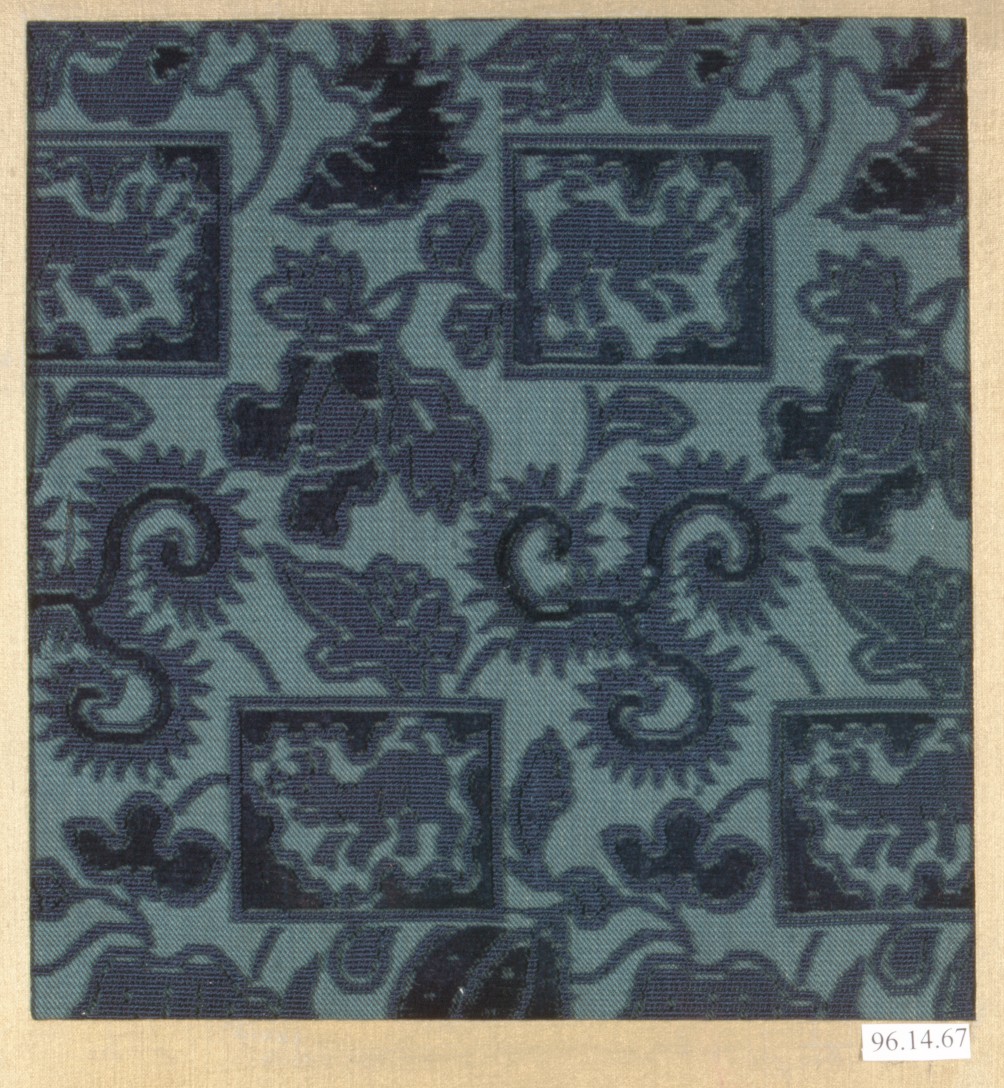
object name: piece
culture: japanese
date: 1701-1800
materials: silk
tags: animals